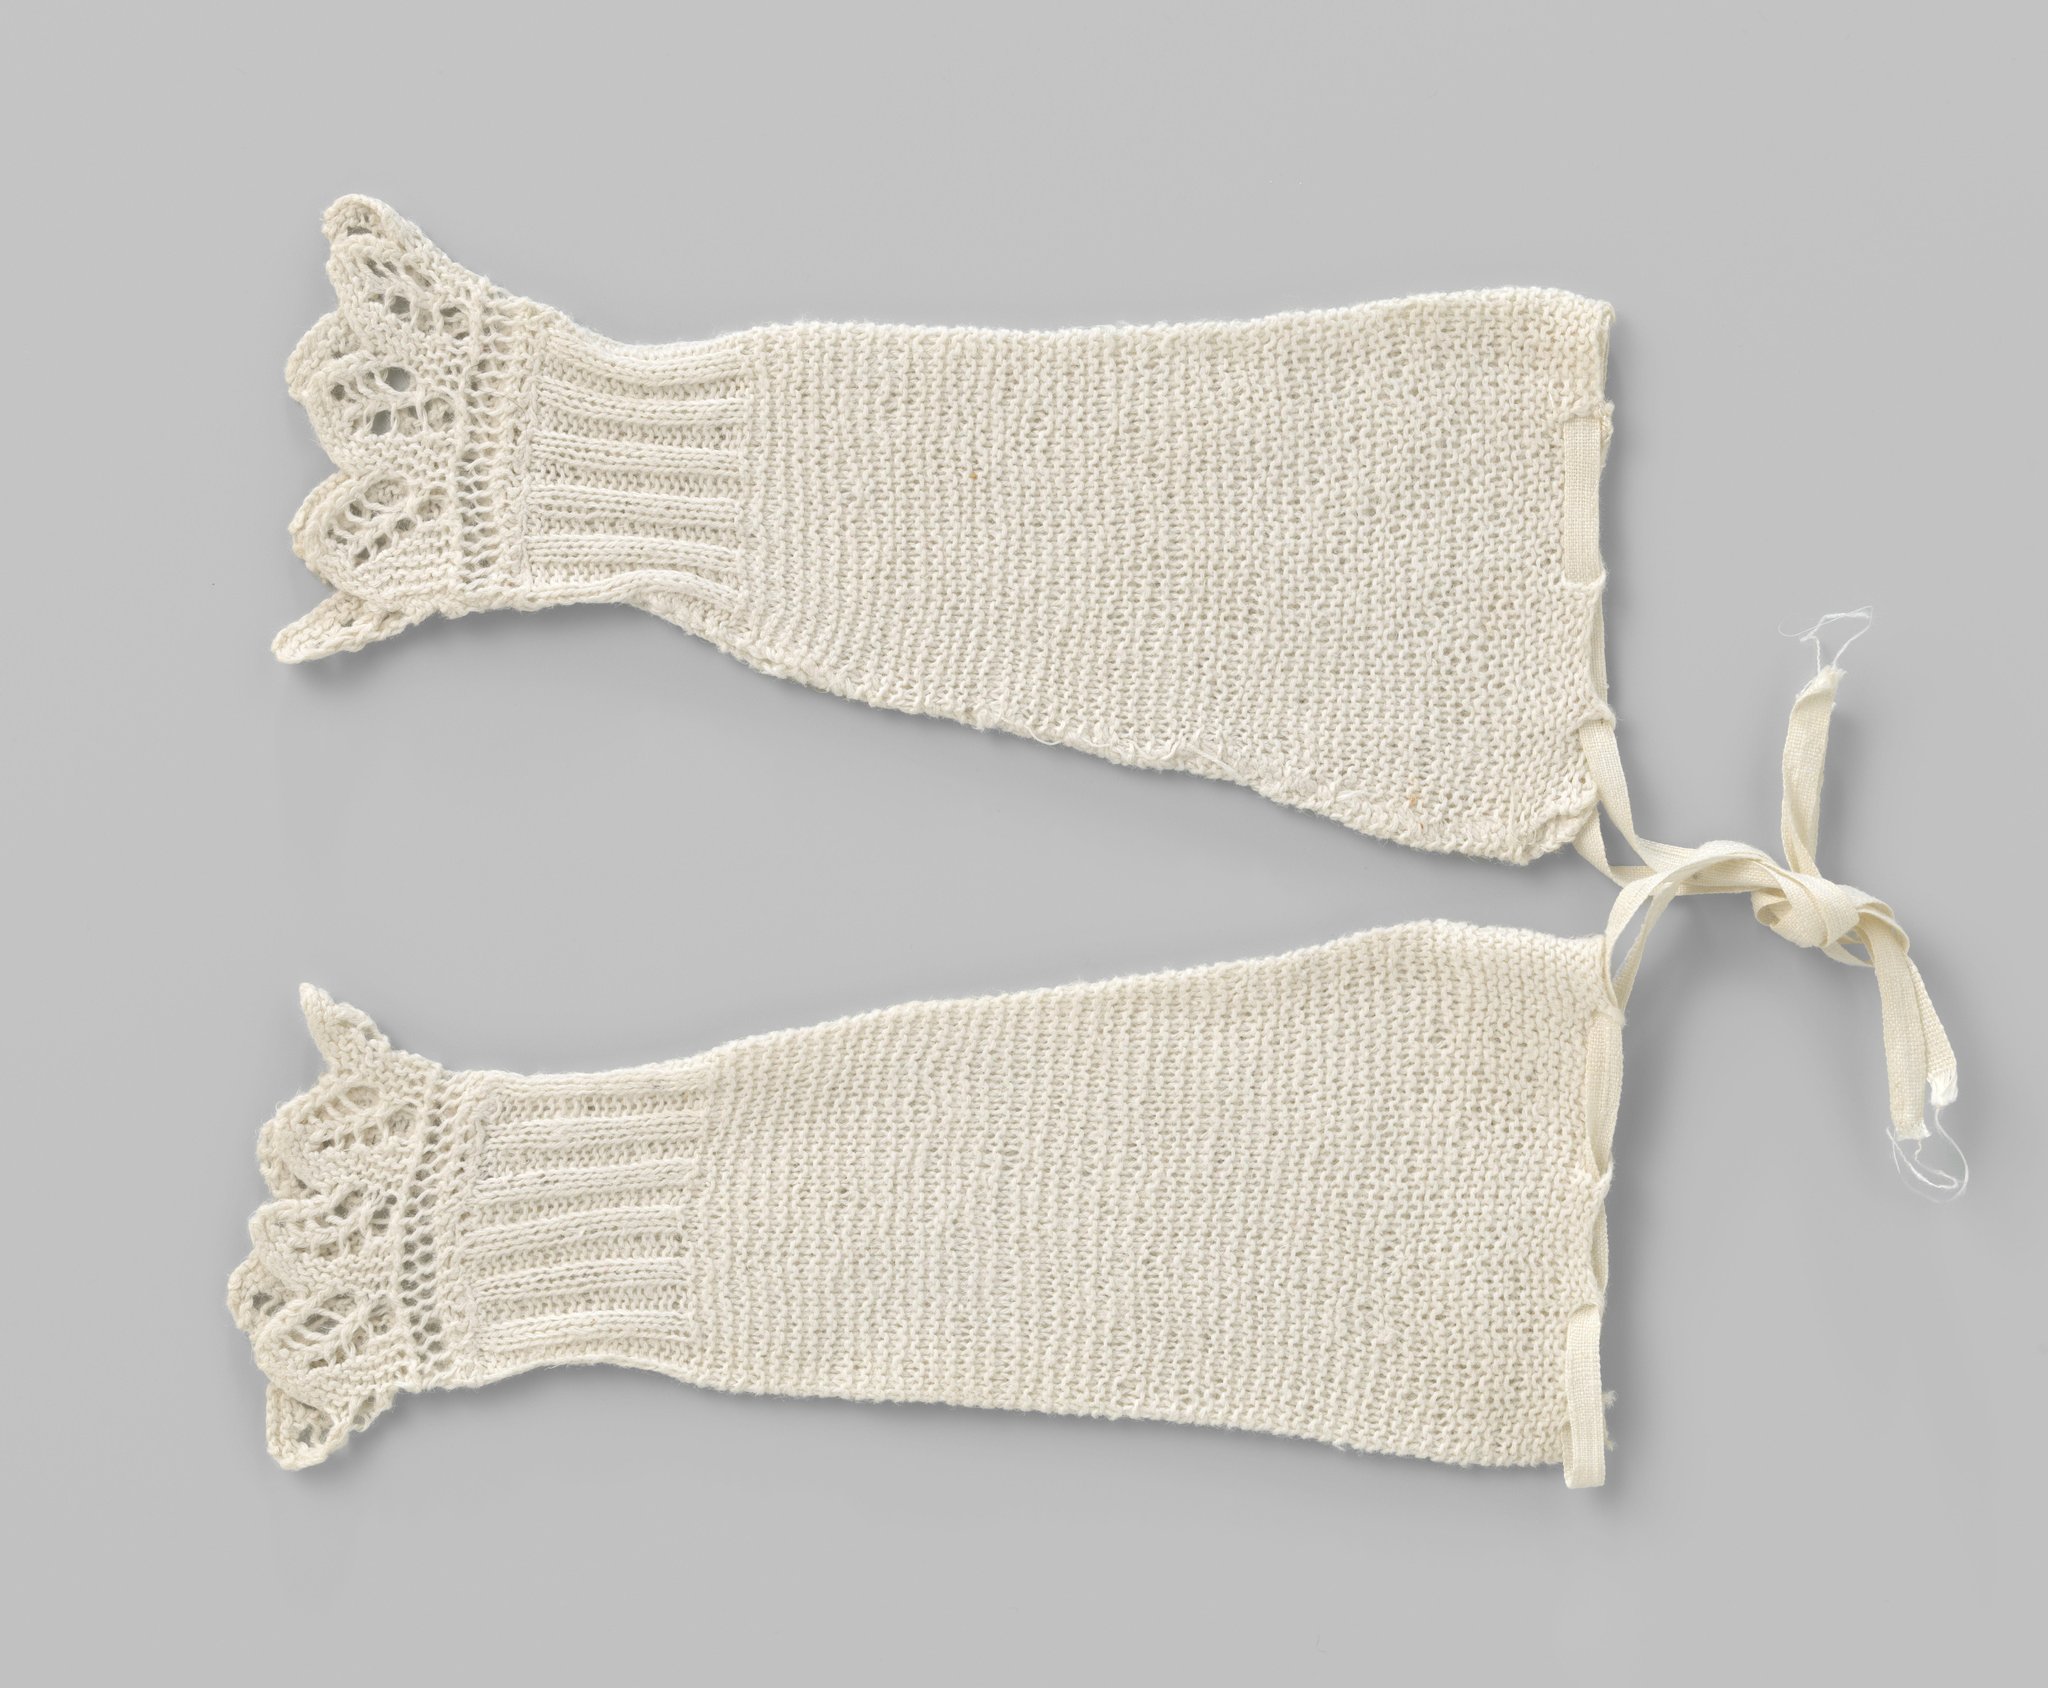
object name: sleeve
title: Witte gebreide babymouw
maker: Anonymous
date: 1800-1899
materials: textile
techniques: knitting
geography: netherlands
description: Door de bovenzijde is een wit lint geregen. Het uiteinde is voorzien van geschulpt ajourwerk.